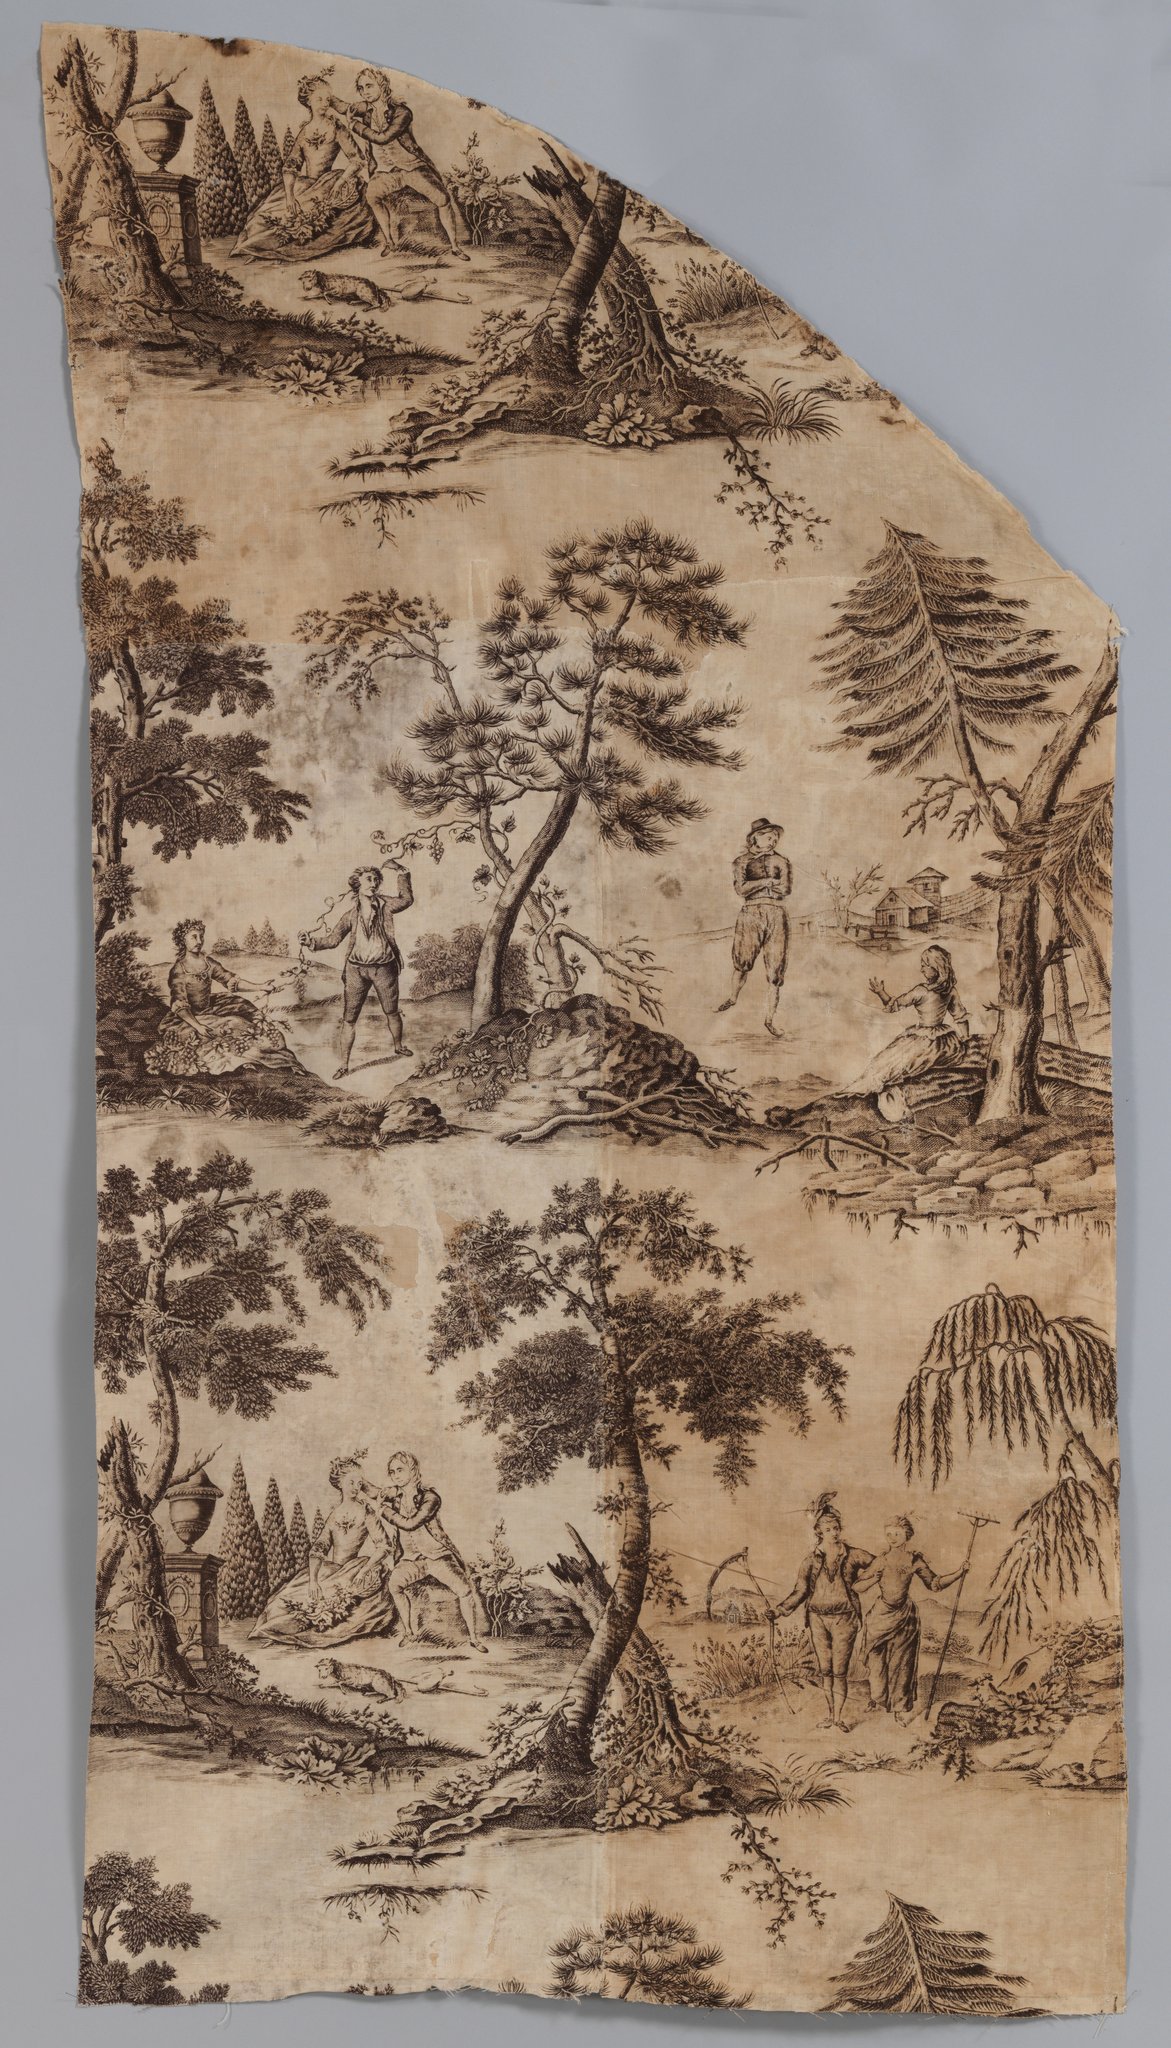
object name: piece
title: Four Seasons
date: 1785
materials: cotton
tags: animals,houses,men,women,trees